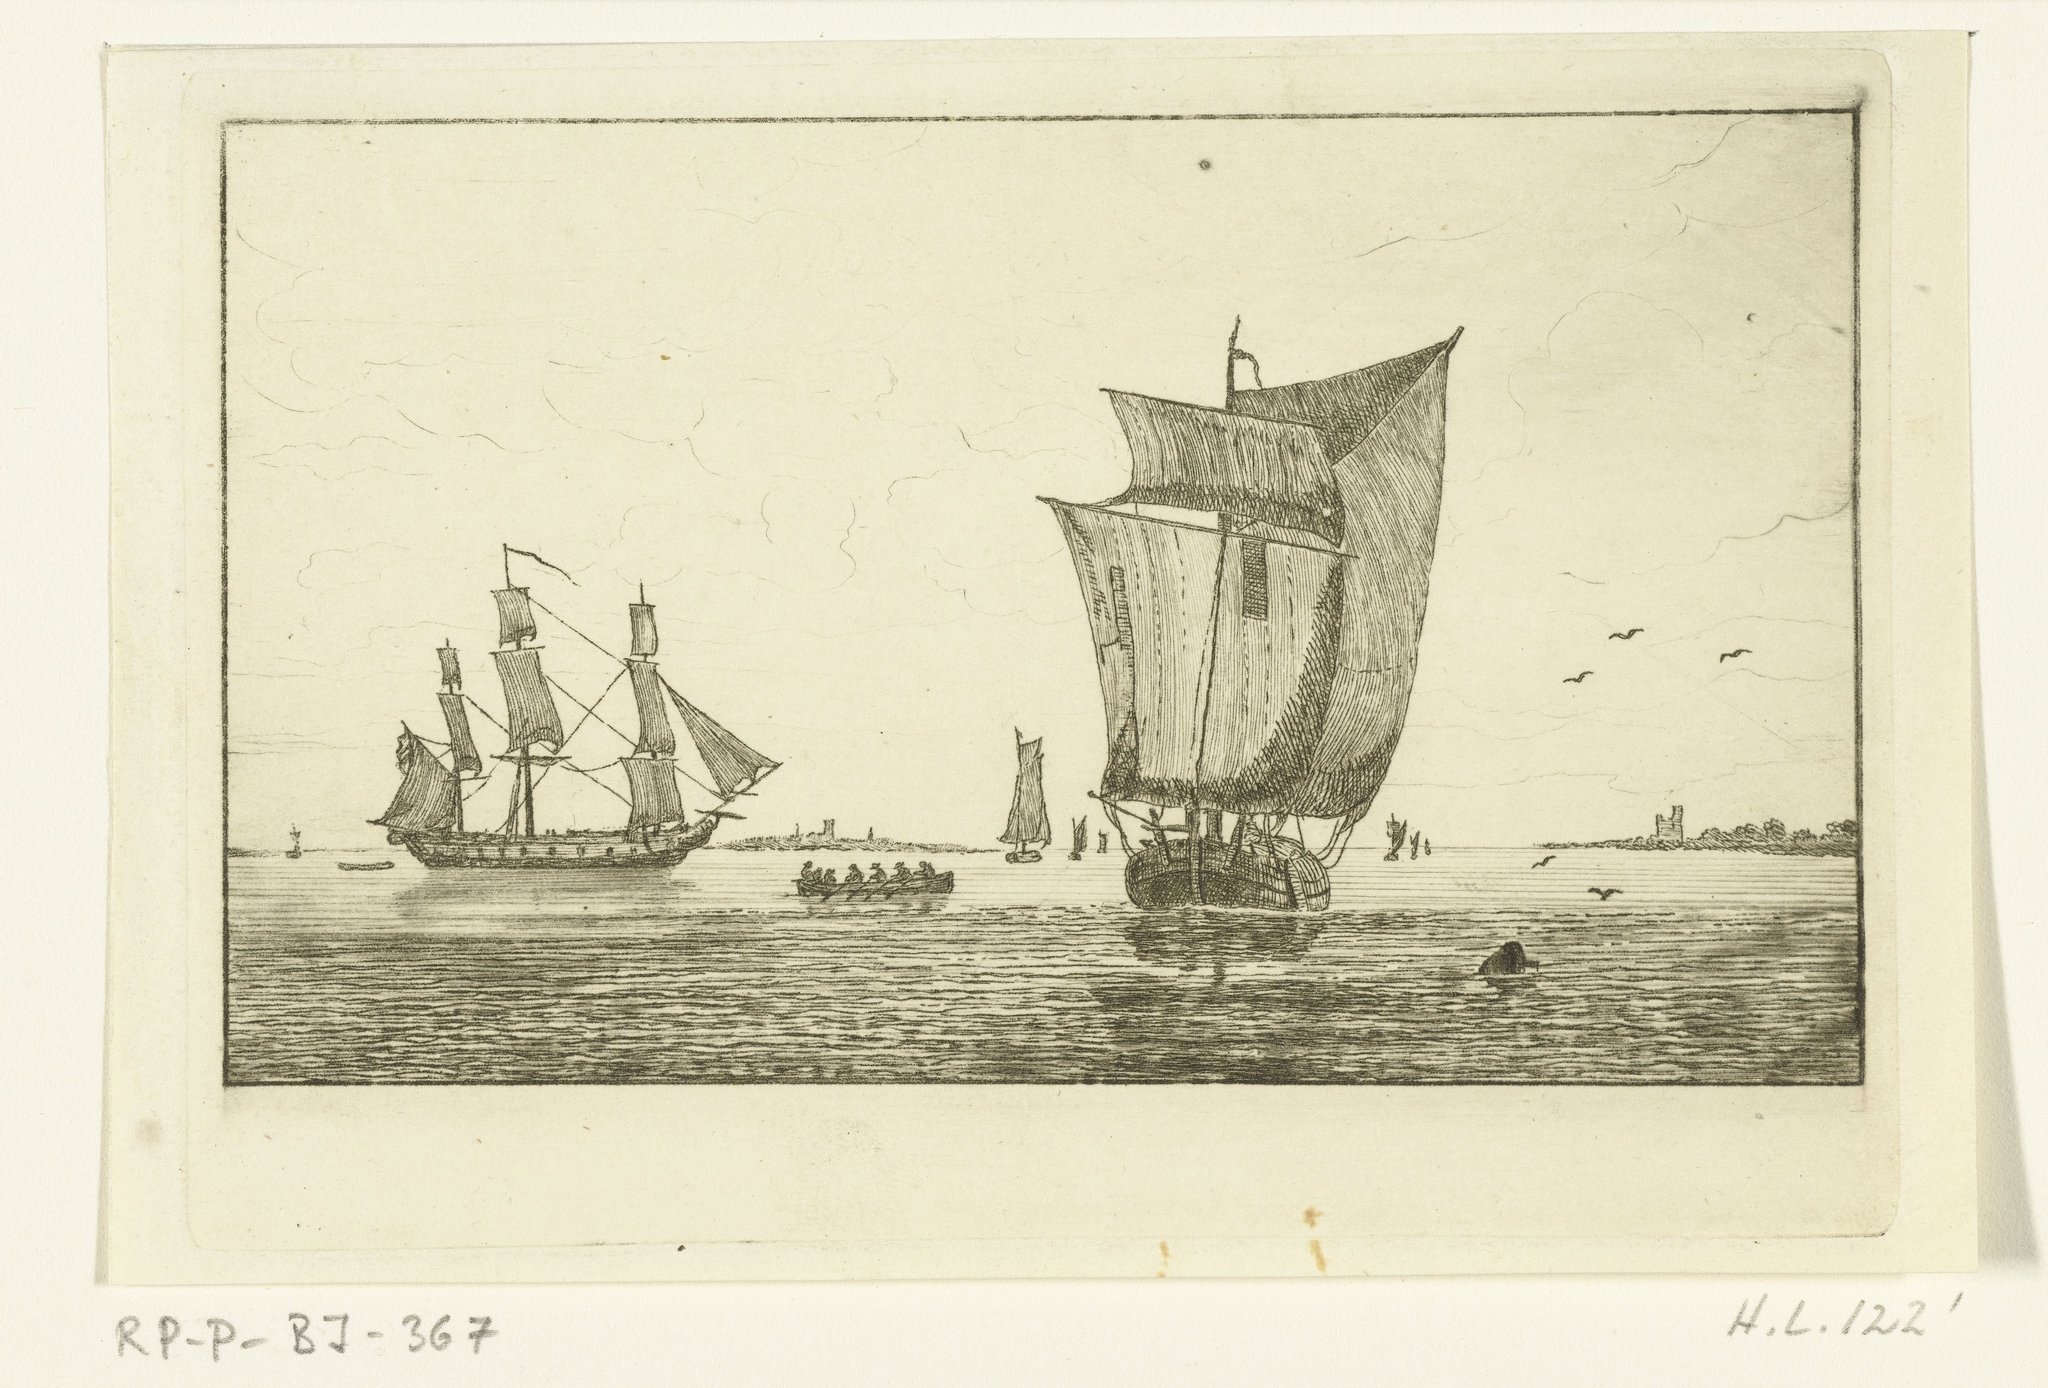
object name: print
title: Riviergezicht met zeilschepen en een roeiboot met zeven personen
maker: ernst willem jan bagelaar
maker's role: draughtsman, print maker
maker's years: 1775-1837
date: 1798-1817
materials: paper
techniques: etching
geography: netherlands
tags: sailing-ship, sailing-boat, rowing-boat, canoe, etc.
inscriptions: collector's mark: Lugt 2228